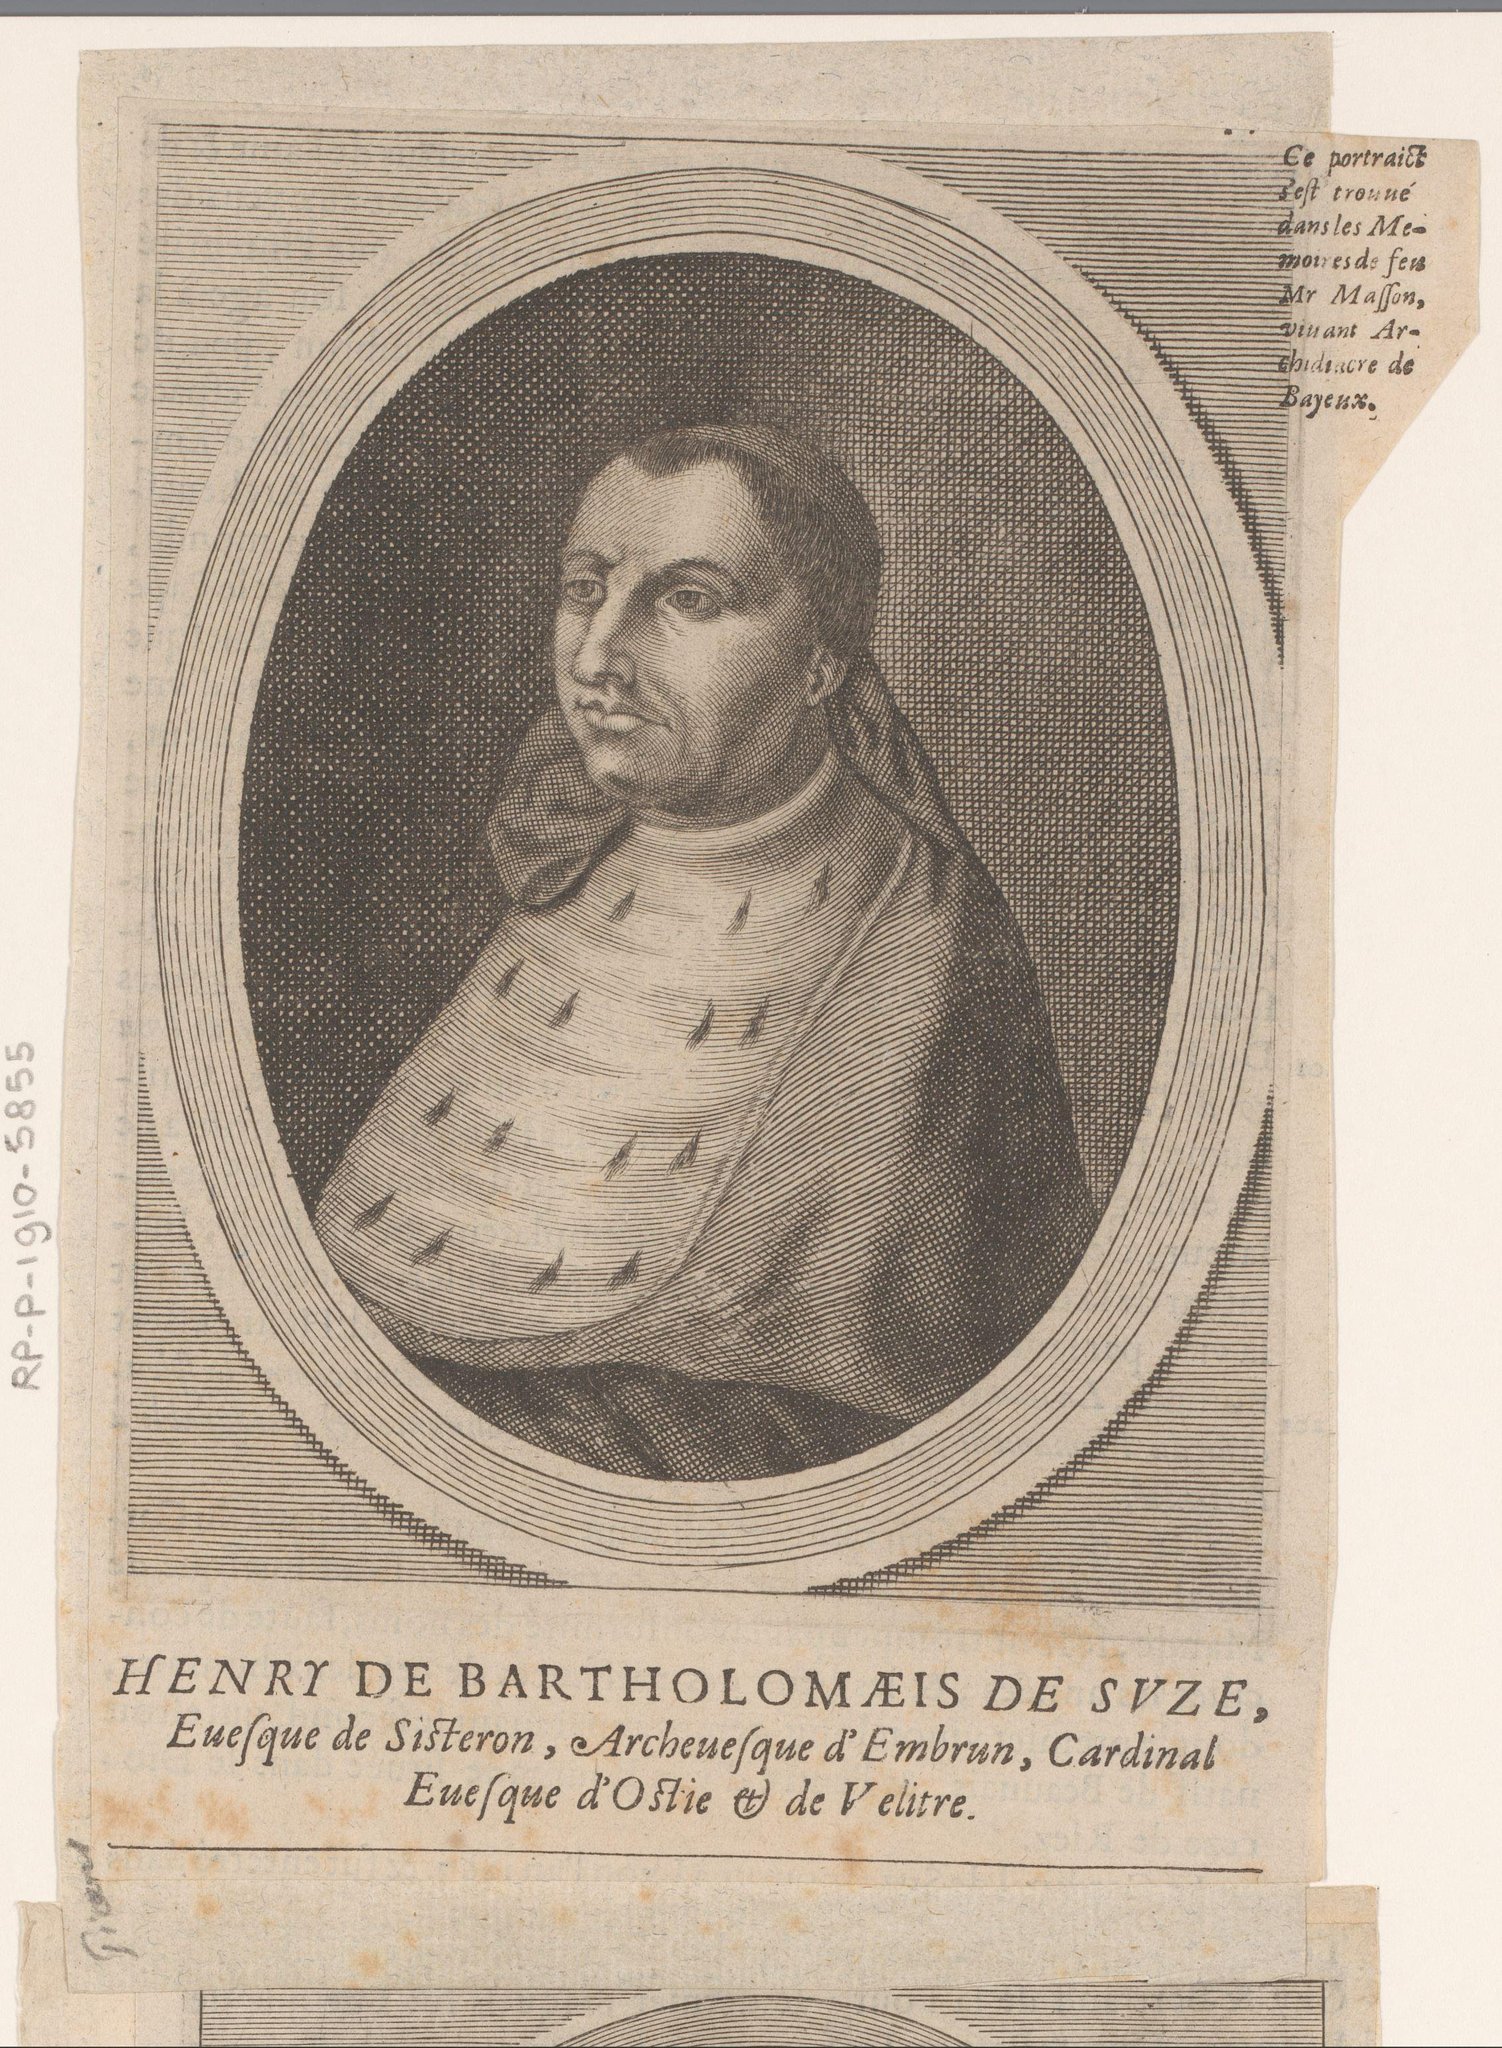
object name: print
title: Henry de Bartholomaeis de Suze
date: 1660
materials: paper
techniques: engraving, etching, letterpress printing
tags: lyon, archbishop, bishop, etc. (roman catholic), historical persons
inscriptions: collector's mark: Lugt 2228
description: Prent uit: Du Chesne, François. Histoire de tous les cardinaux françois de naissance, ou qui ont esté promeus au cardinalat. Parijs: François Du Chesne, 1660.